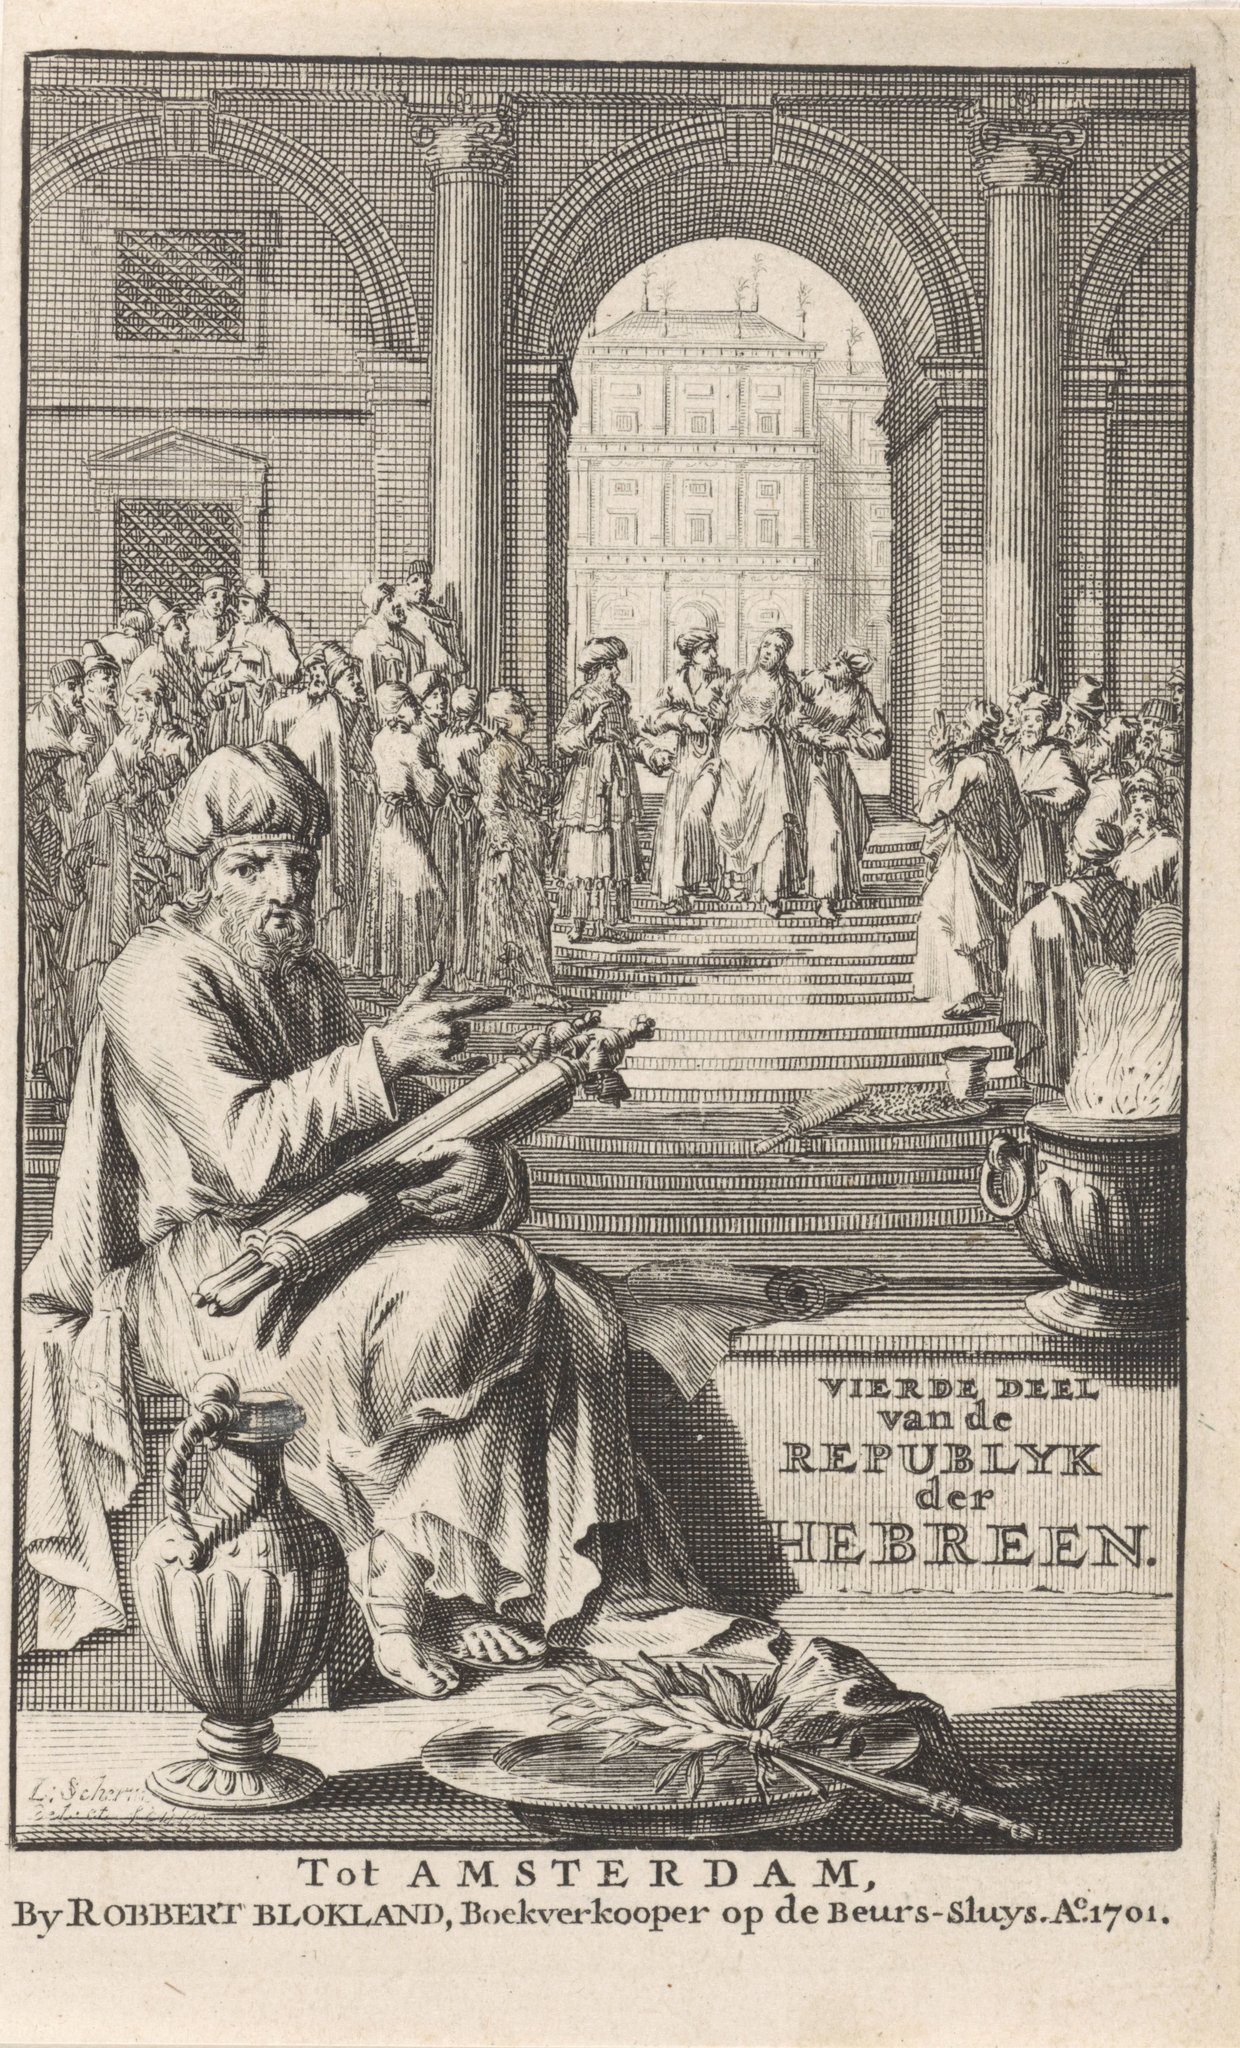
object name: titelblad, titelpagina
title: Joden in een tempel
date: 1701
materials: paper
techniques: etching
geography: amsterdam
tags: tabernacle, temple, synagogue, and other sanctuaries ~ jewish religion, title-page, scroll, the jews, jewish life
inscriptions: collector's mark: Lugt 2228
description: In een tempel kijkt een groep Joden toe hoe een vrouw door twee mannen naar beneden wordt gevoerd, omdat ze in staat van beschuldiging is gesteld. Linksvoor zit een Joodse profeet met een schriftrol op zijn schoot.